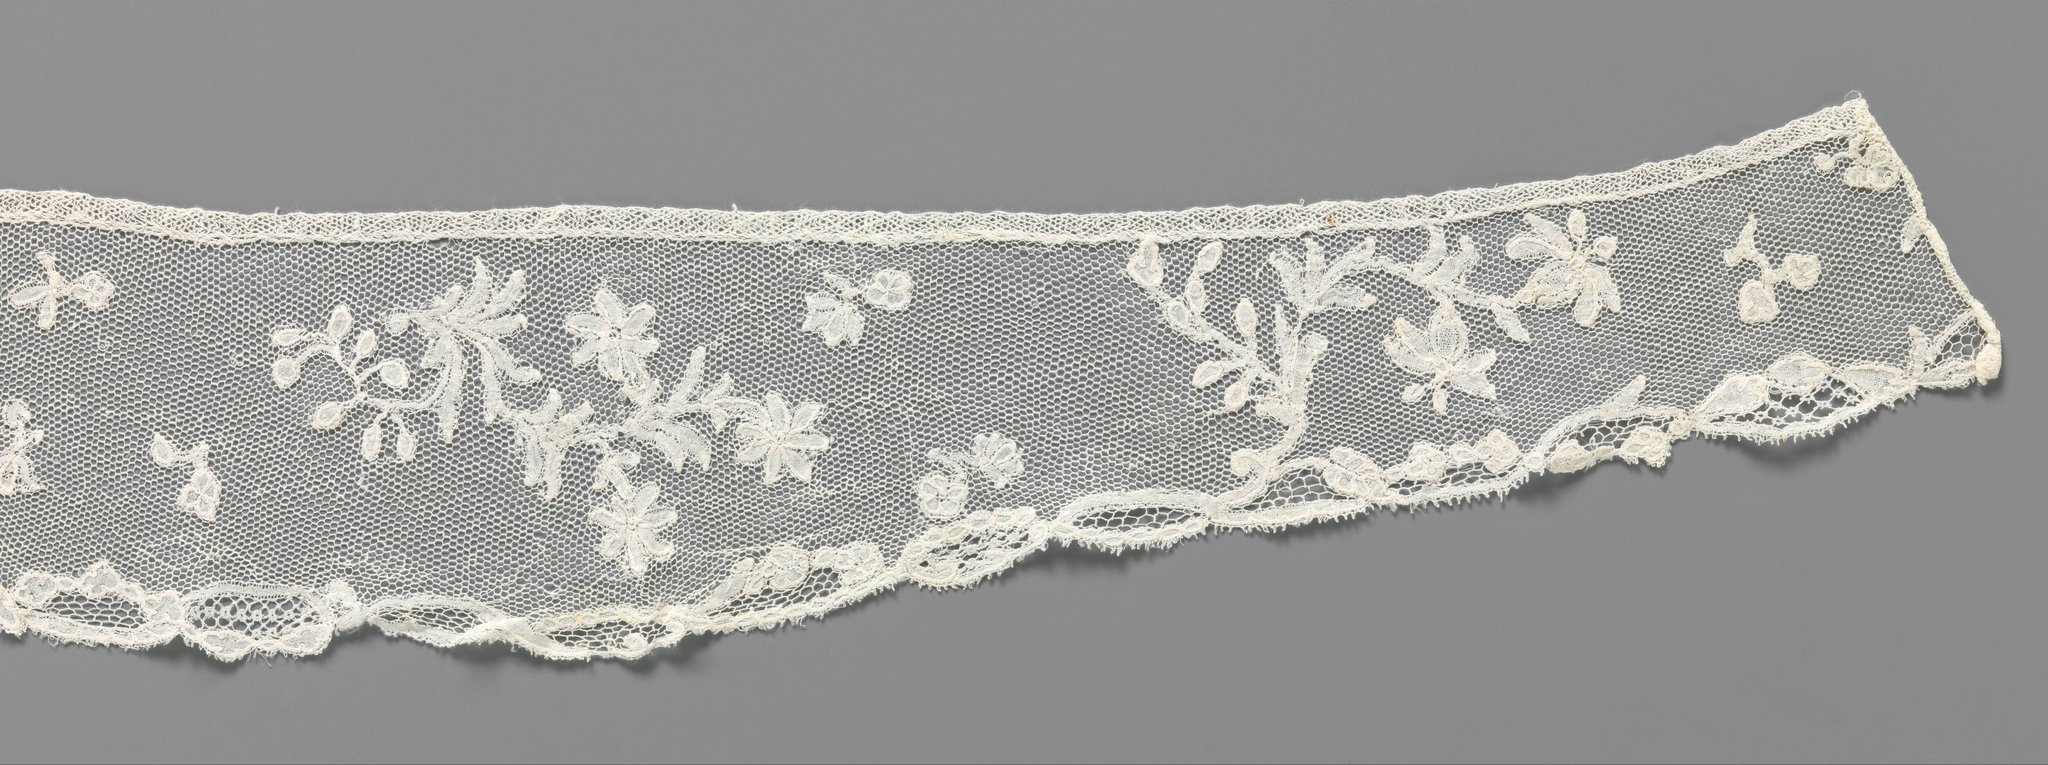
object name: engageante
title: Engageante van kloskant met verschillende bloemtakken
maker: Anonymous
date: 1750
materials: linen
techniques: lace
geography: brussels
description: Engageante van naturelkleurige kloskant: Brusselse kloskant. Het patroon bestaat uit verschillende bloemtakken waartussen strooibloemen. De motieven zijn met elkaar verbonden door een traliegrond, een drochelgrond. De engageante heeft een flauw geschulpte rand van aaneengeschakelde cartouches die min of meer ovaal van vorm zijn en gevuld met grovere traliegronden dan in het patroon daarboven en enkele siergrondjes.